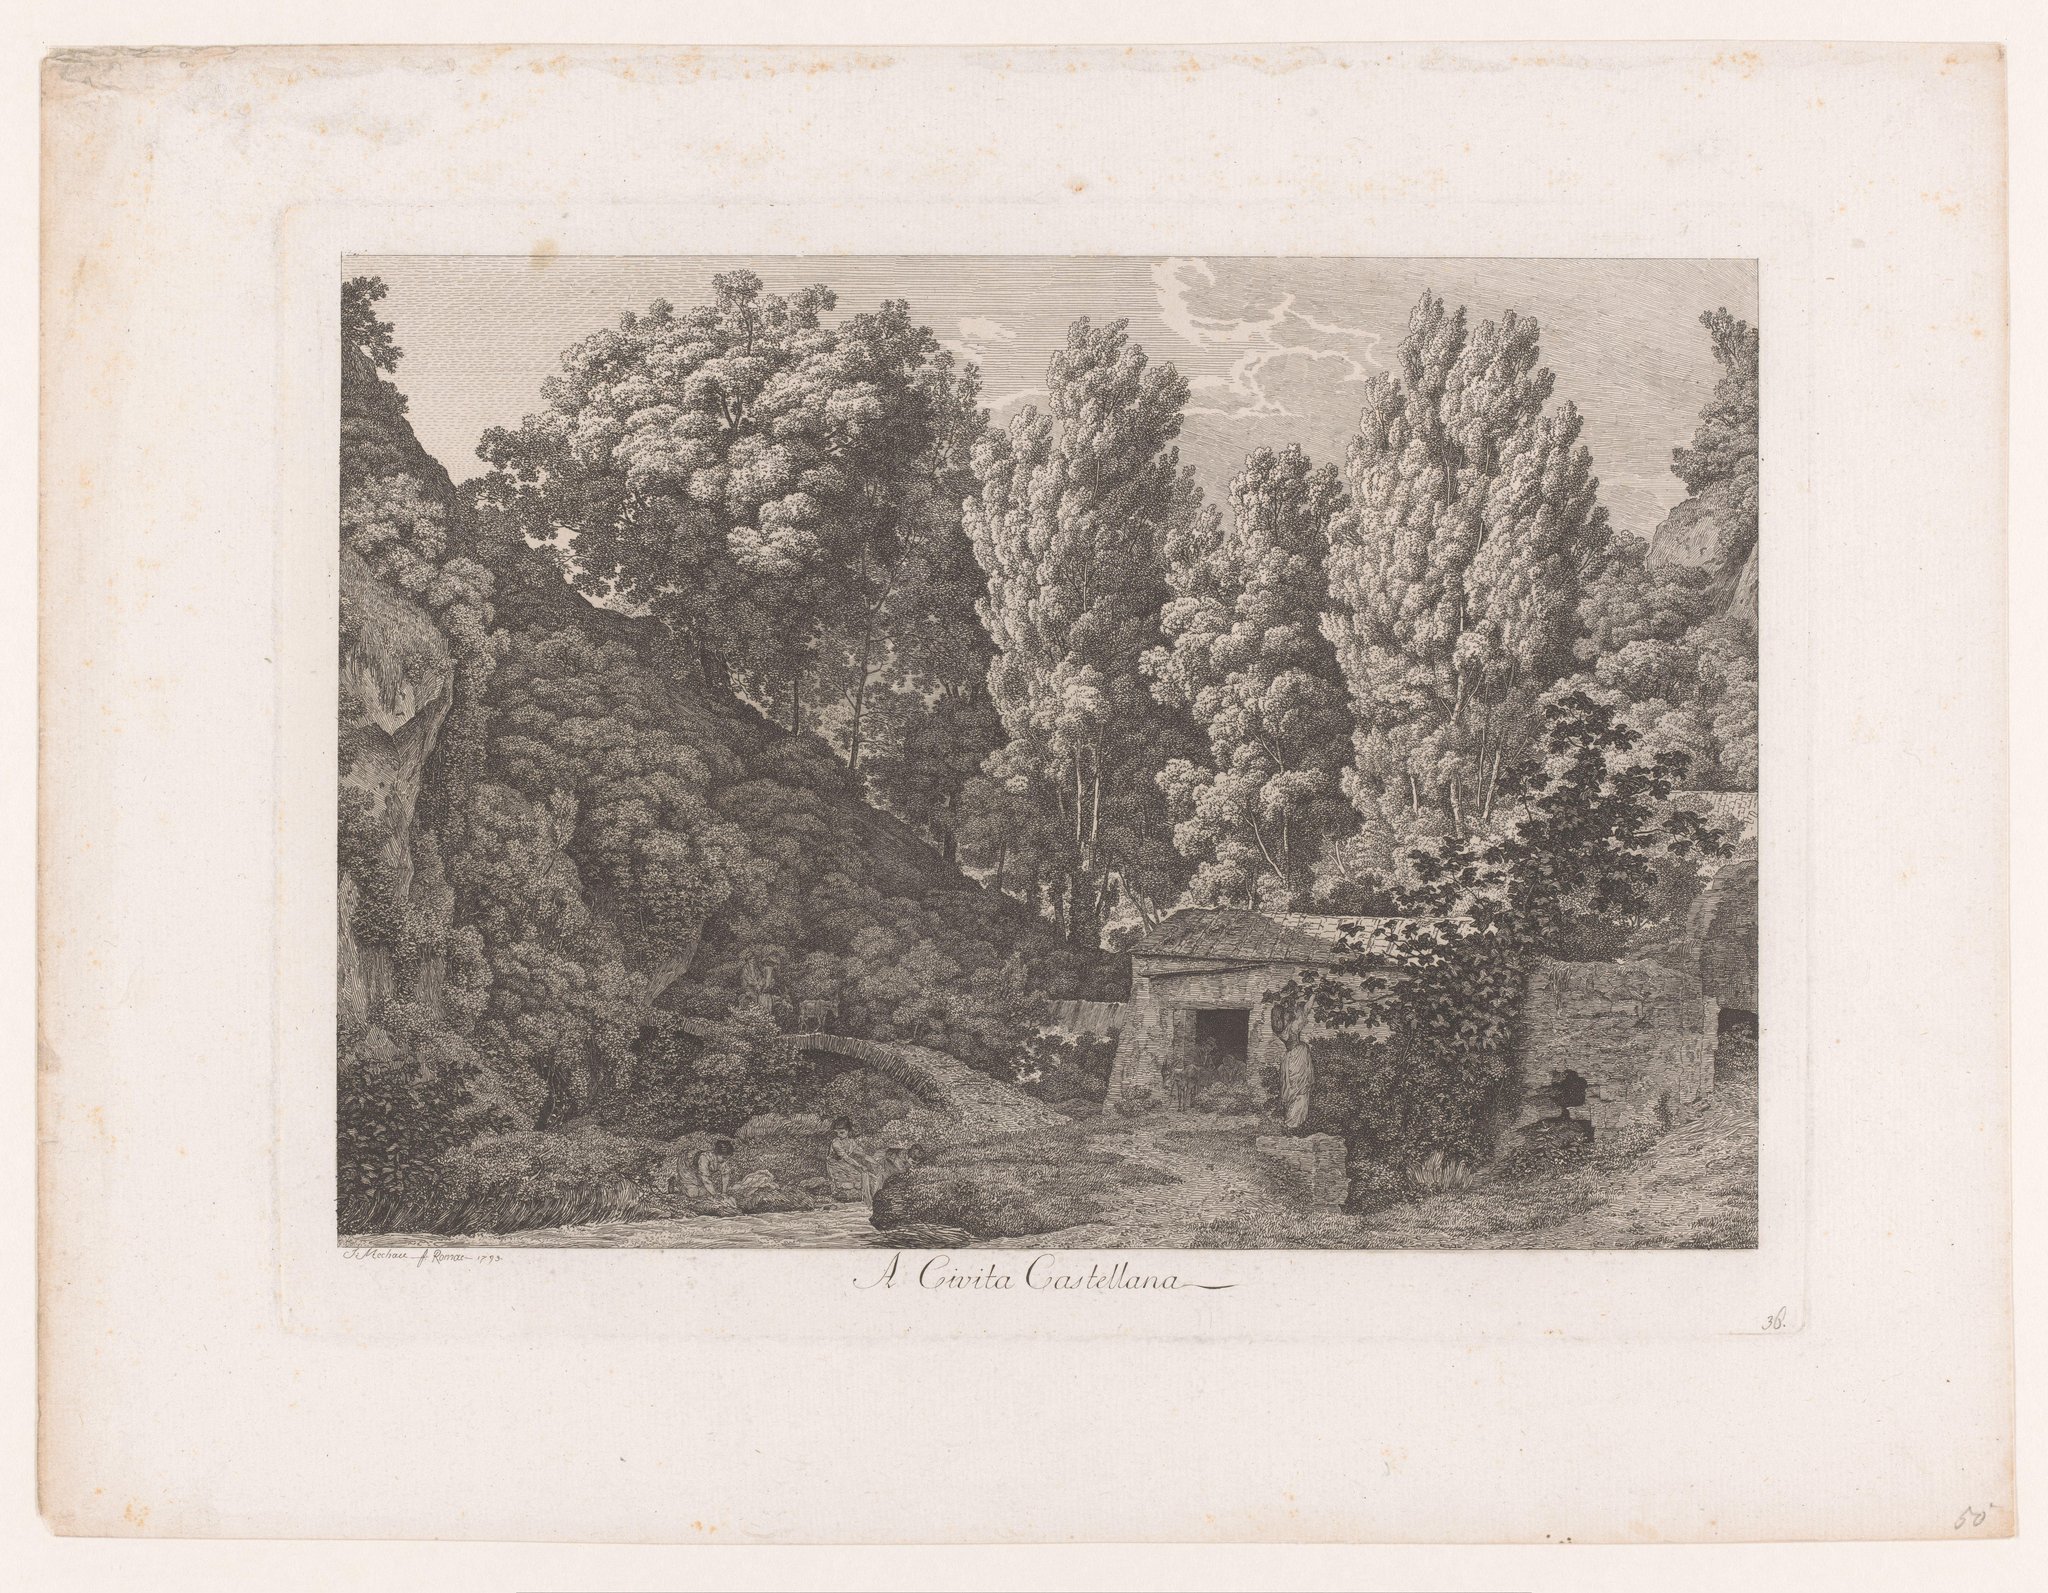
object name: print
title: A Civita Castellana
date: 1793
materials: paper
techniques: etching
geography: rome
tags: landscapes (+ landscape with figures, staffage)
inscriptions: collector's mark: Lugt 2228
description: Behorend tot een set van 72 'Mahlerisch-radirte Prospecte von Italien', waarvoor de kunstenaar 24 prenten maakte. Albert Christoph Dies (1755-1822) en Johann Christian Reinhart (1761-1847) maakten eveneens 24 platen, in opdracht van Jean Fréderic Frauenholz.